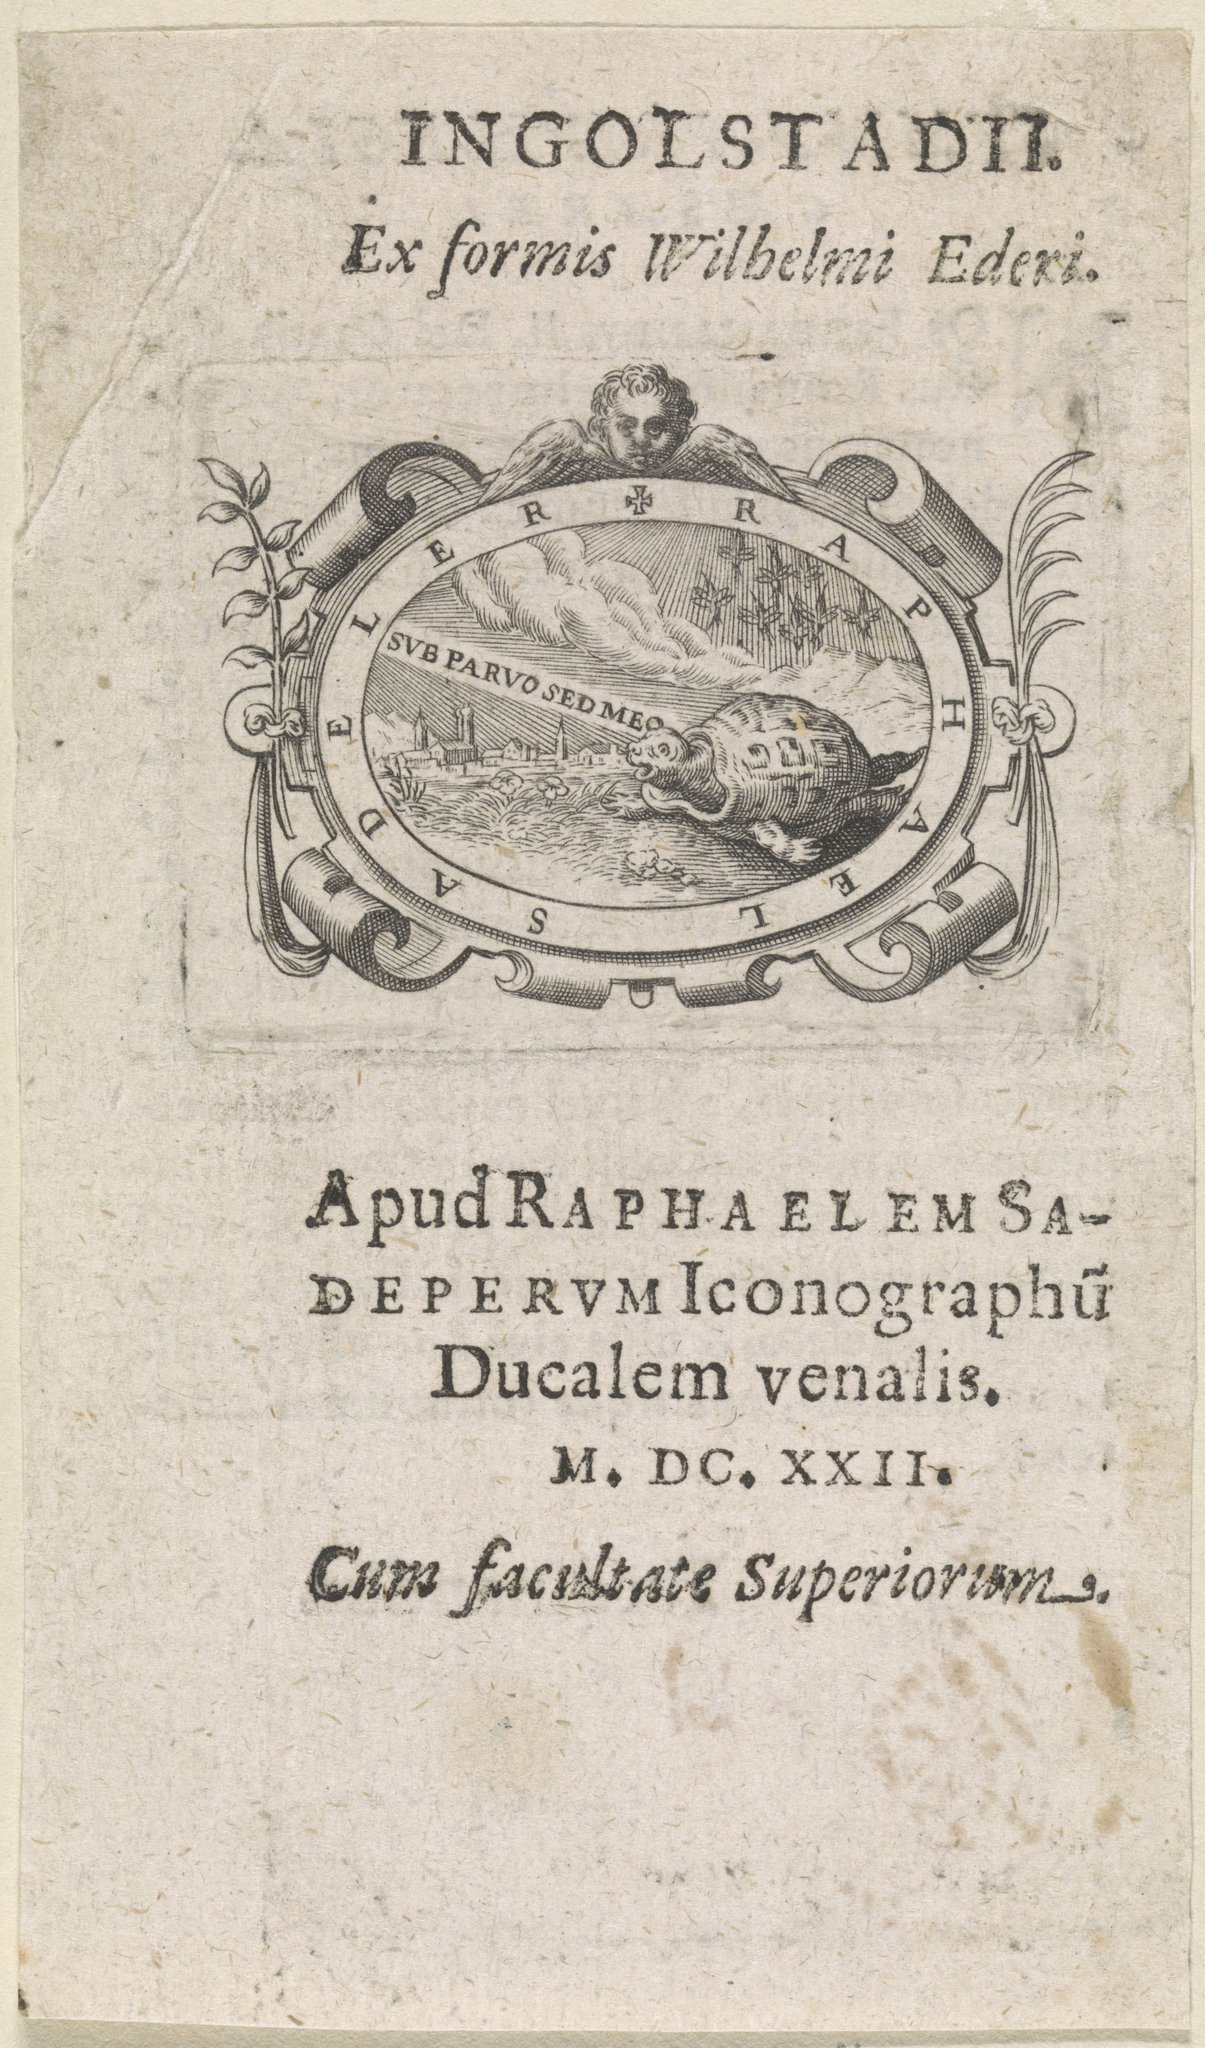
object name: print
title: Schildpad in een ovale omlijsting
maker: wilhelm eder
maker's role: publisher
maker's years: -1660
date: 1622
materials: paper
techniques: engraving, letterpress printing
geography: ingolstadt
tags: tortoises, turtles, device (trade-mark of printer or publisher)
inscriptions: collector's mark: Lugt 240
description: Prent uit: Bruma, Erycus Puteanus. Aenigma Regium, infantiam populi r. Complectens. Ingolstadt en München: Wilhelm Eder en Raphaël Sadeler (I) of (II), 1623.